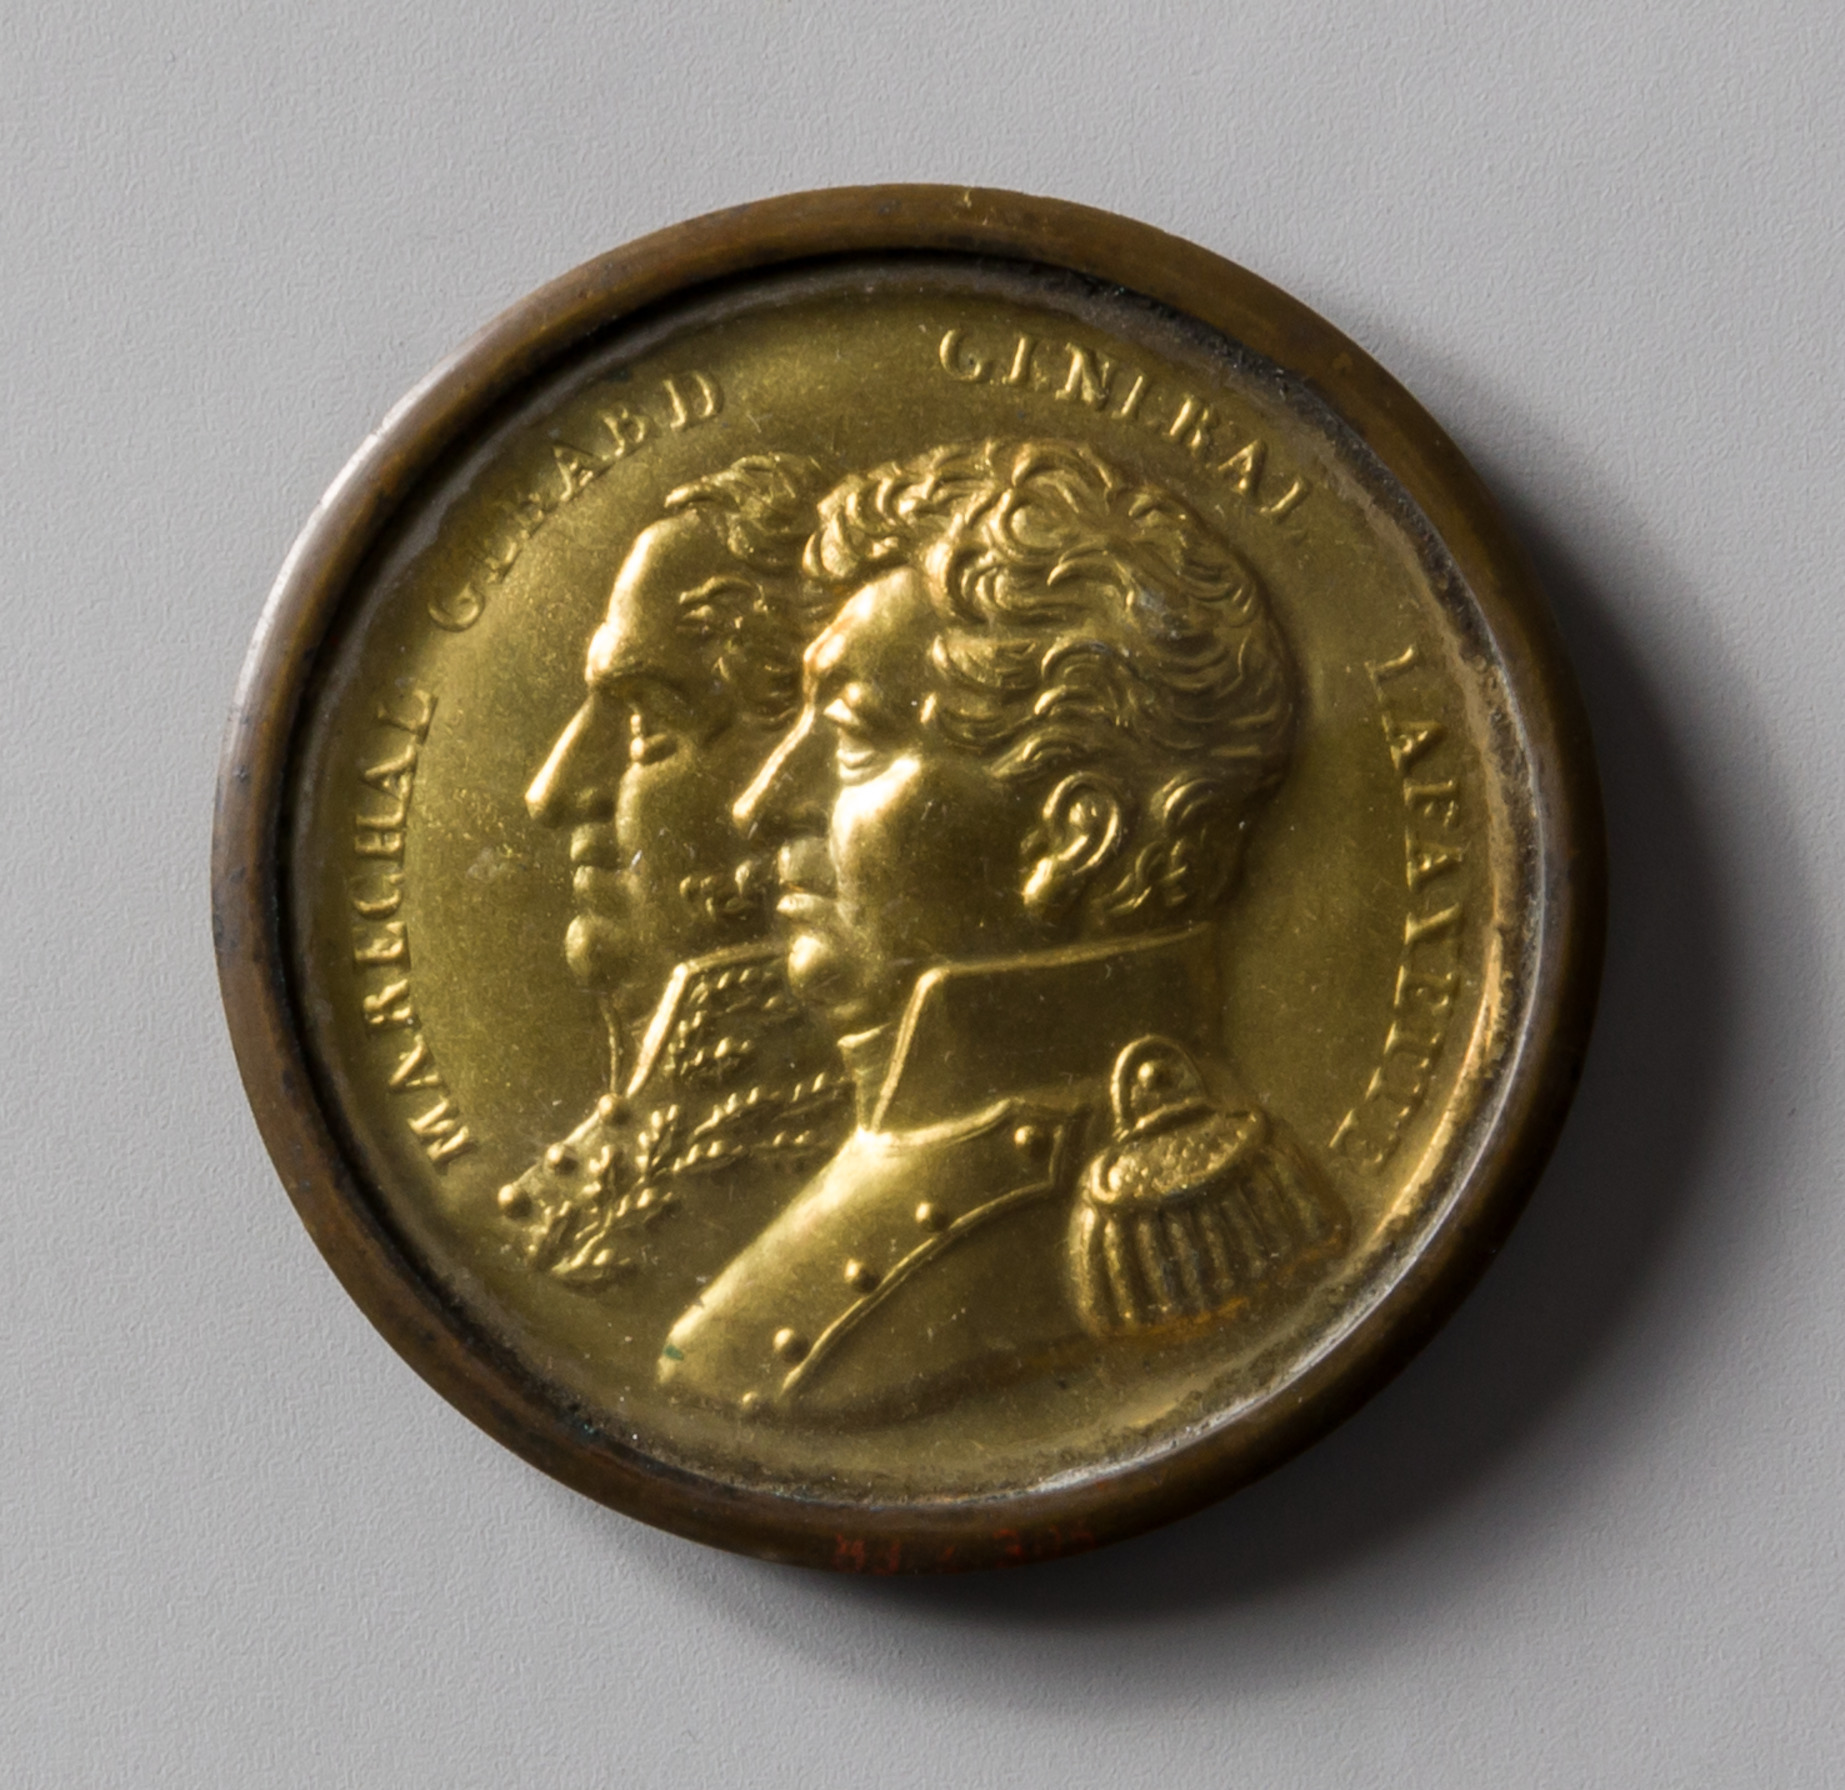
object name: plaque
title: Disk of General Lafayette and Marshal Gerard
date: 1830-1835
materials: brass, copper, gilt, glass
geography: france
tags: men,profiles,marquis de lafayette